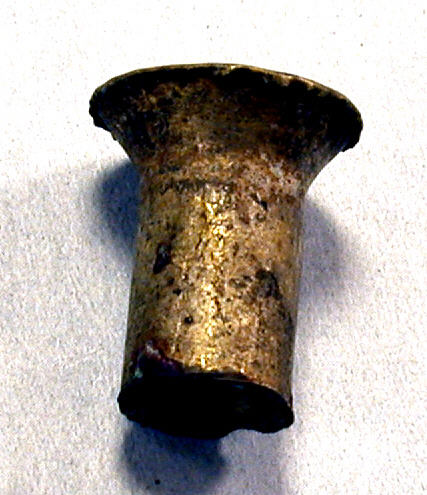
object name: ornament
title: Hammered Silver Drum Ornament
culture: peruvian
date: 701-1566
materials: gilt, silver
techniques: hammering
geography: peru